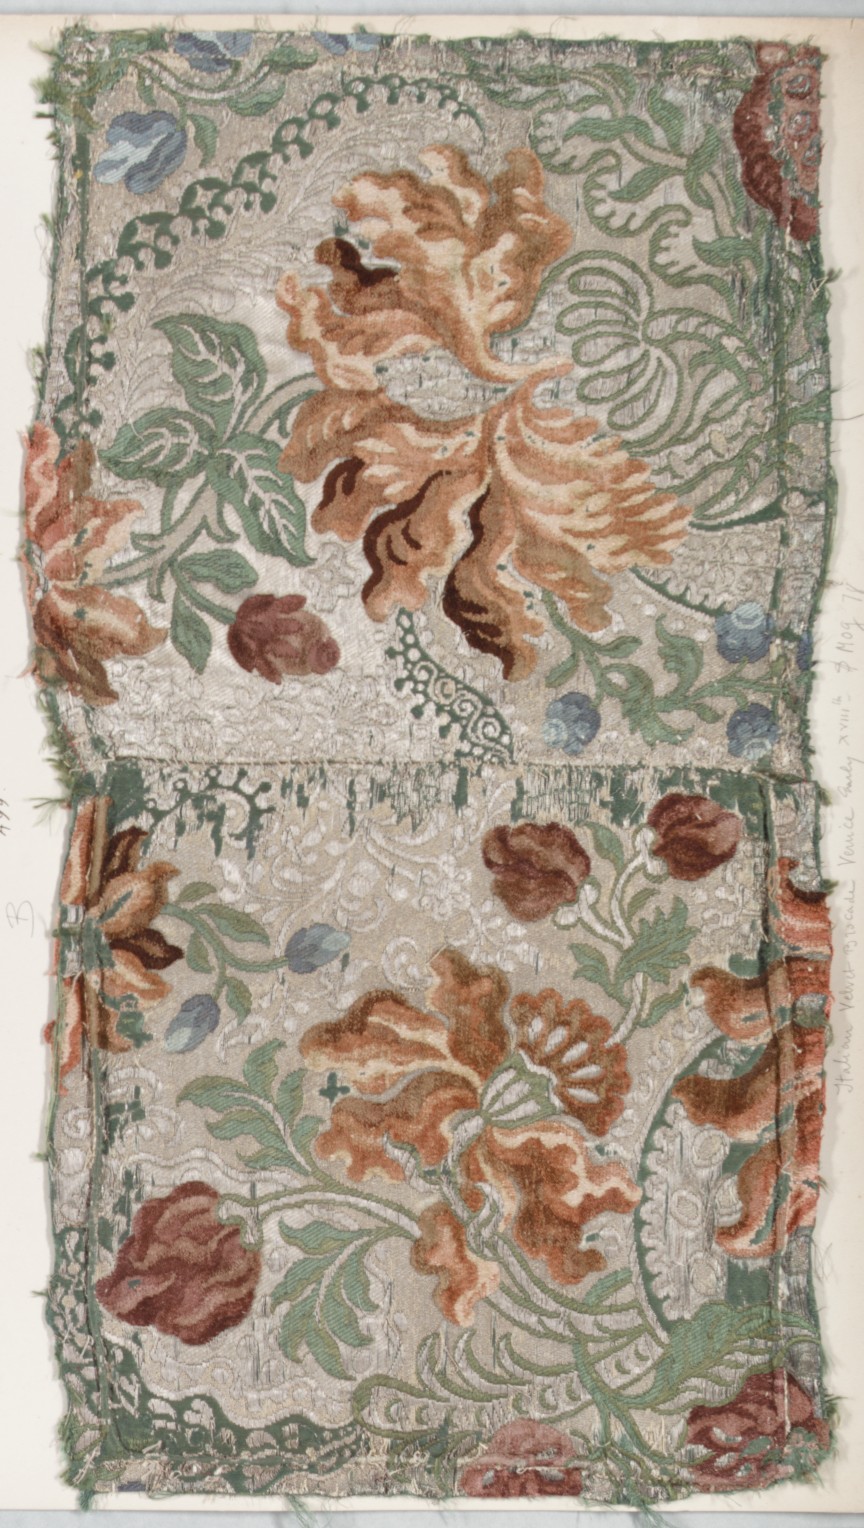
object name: fragment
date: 1701-1800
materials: metal thread, silk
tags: flowers,leaves